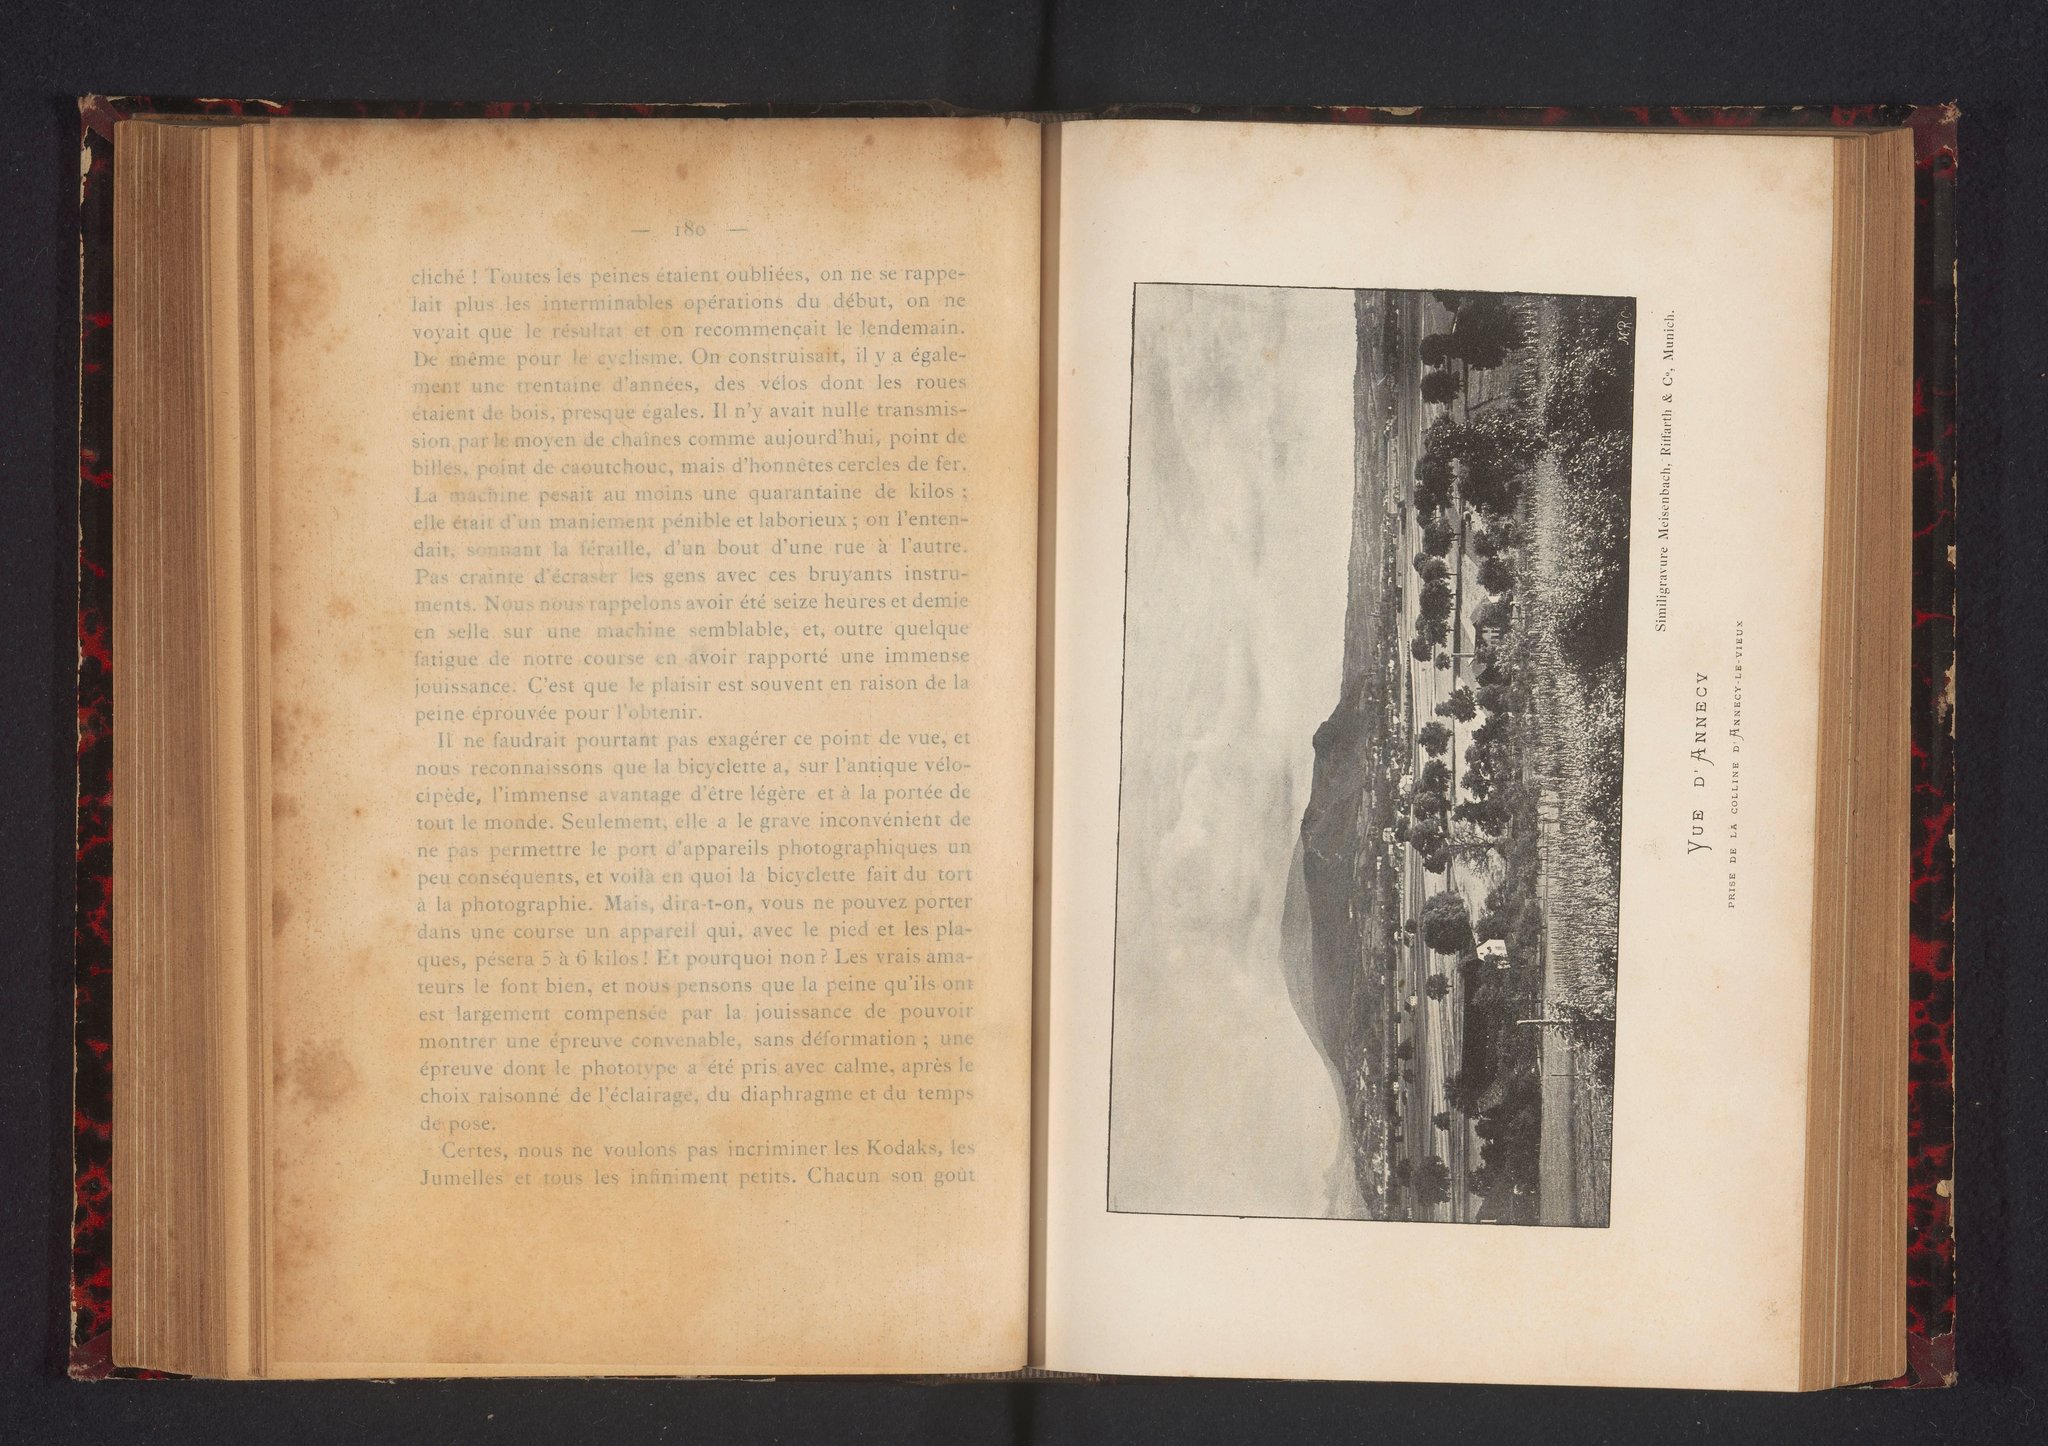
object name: photomechanical print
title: Gezicht op Annecy, Frankrijk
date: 1893-1898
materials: paper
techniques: autotype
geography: munich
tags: prospect of village, silhouette of village, landscapes